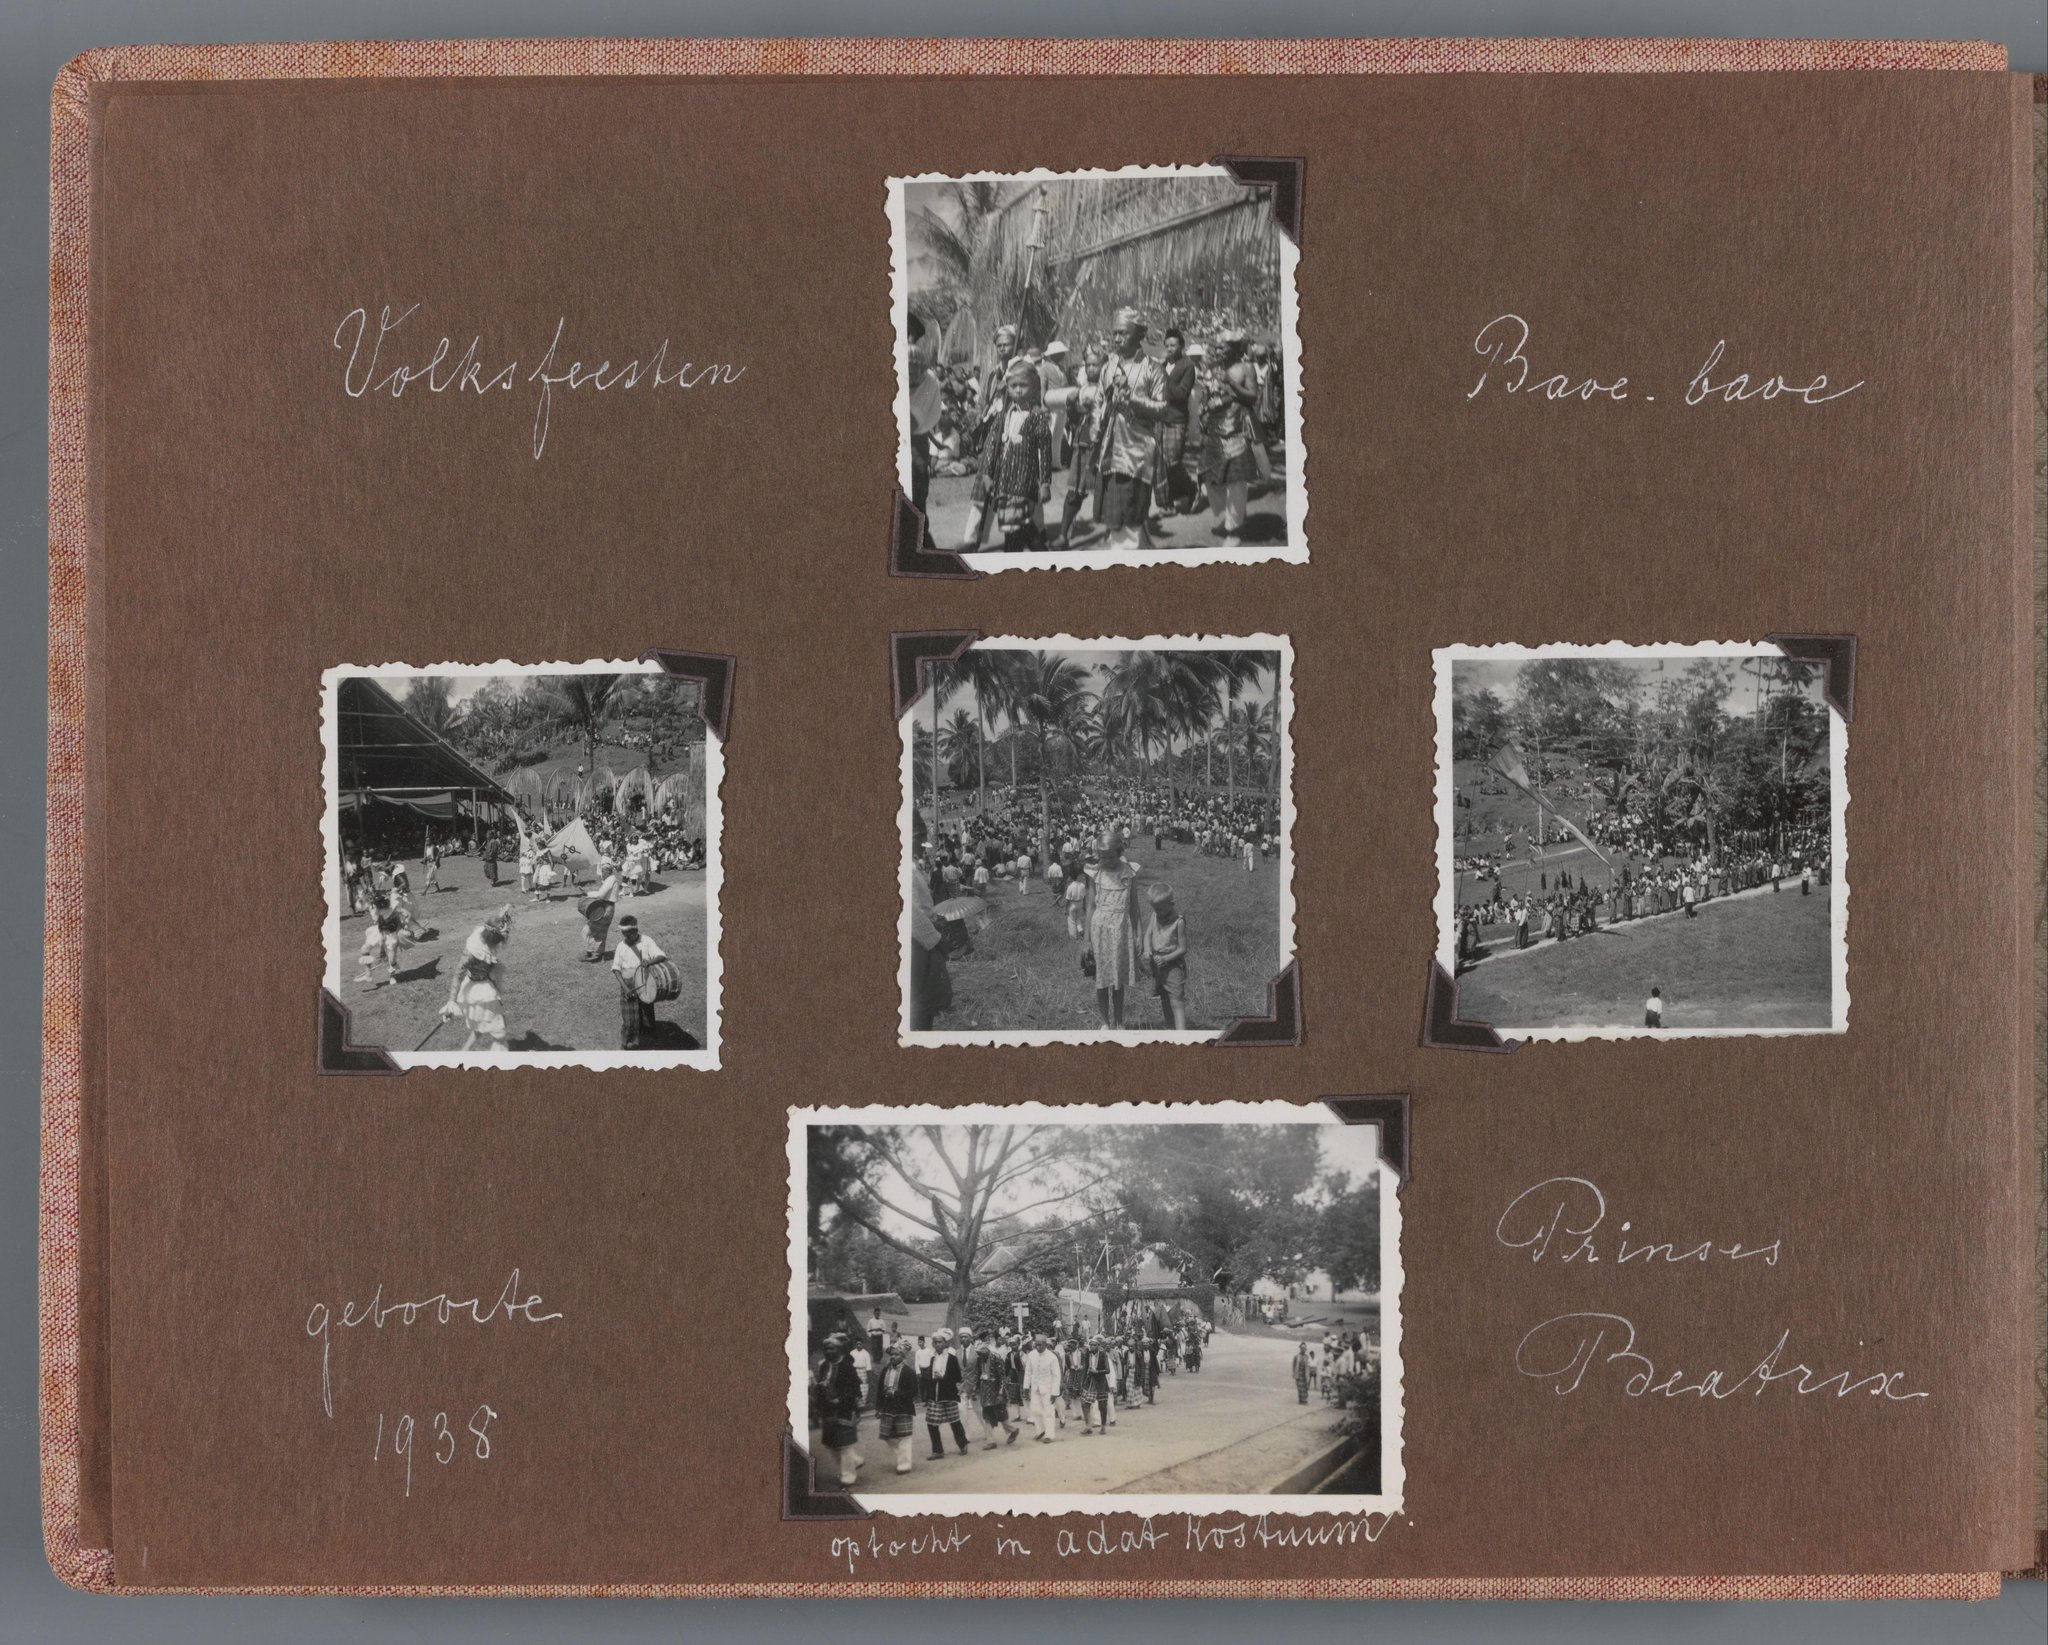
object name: album leaf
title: Volksfeesten Baoe-baoe geboorte Prinses Beatrix 1938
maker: Anonymous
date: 1938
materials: cardboard, photographic support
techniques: gelatin silver print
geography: celebes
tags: beatrix (koningin der nederlanden), r.h. vonk, asiatic races and peoples (indonesians), public festivities at birth of royal persons, folk costume, regional costume, colonial government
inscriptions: inscription: ‘Volksfeesten Baoe-baoe geboorte Prinses Beatrix 1938’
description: Albumblad met vijf foto's van de volksfeesten te Baubau (Baoe-Baoe) op Zuid-Celebes ter gelegenheid van de geboorte van prinses Beatrix in 1938. Ook een optocht in adat kostuum. Onderdeel van het fotoalbum van familie Vonk op Zuid-Celebes.